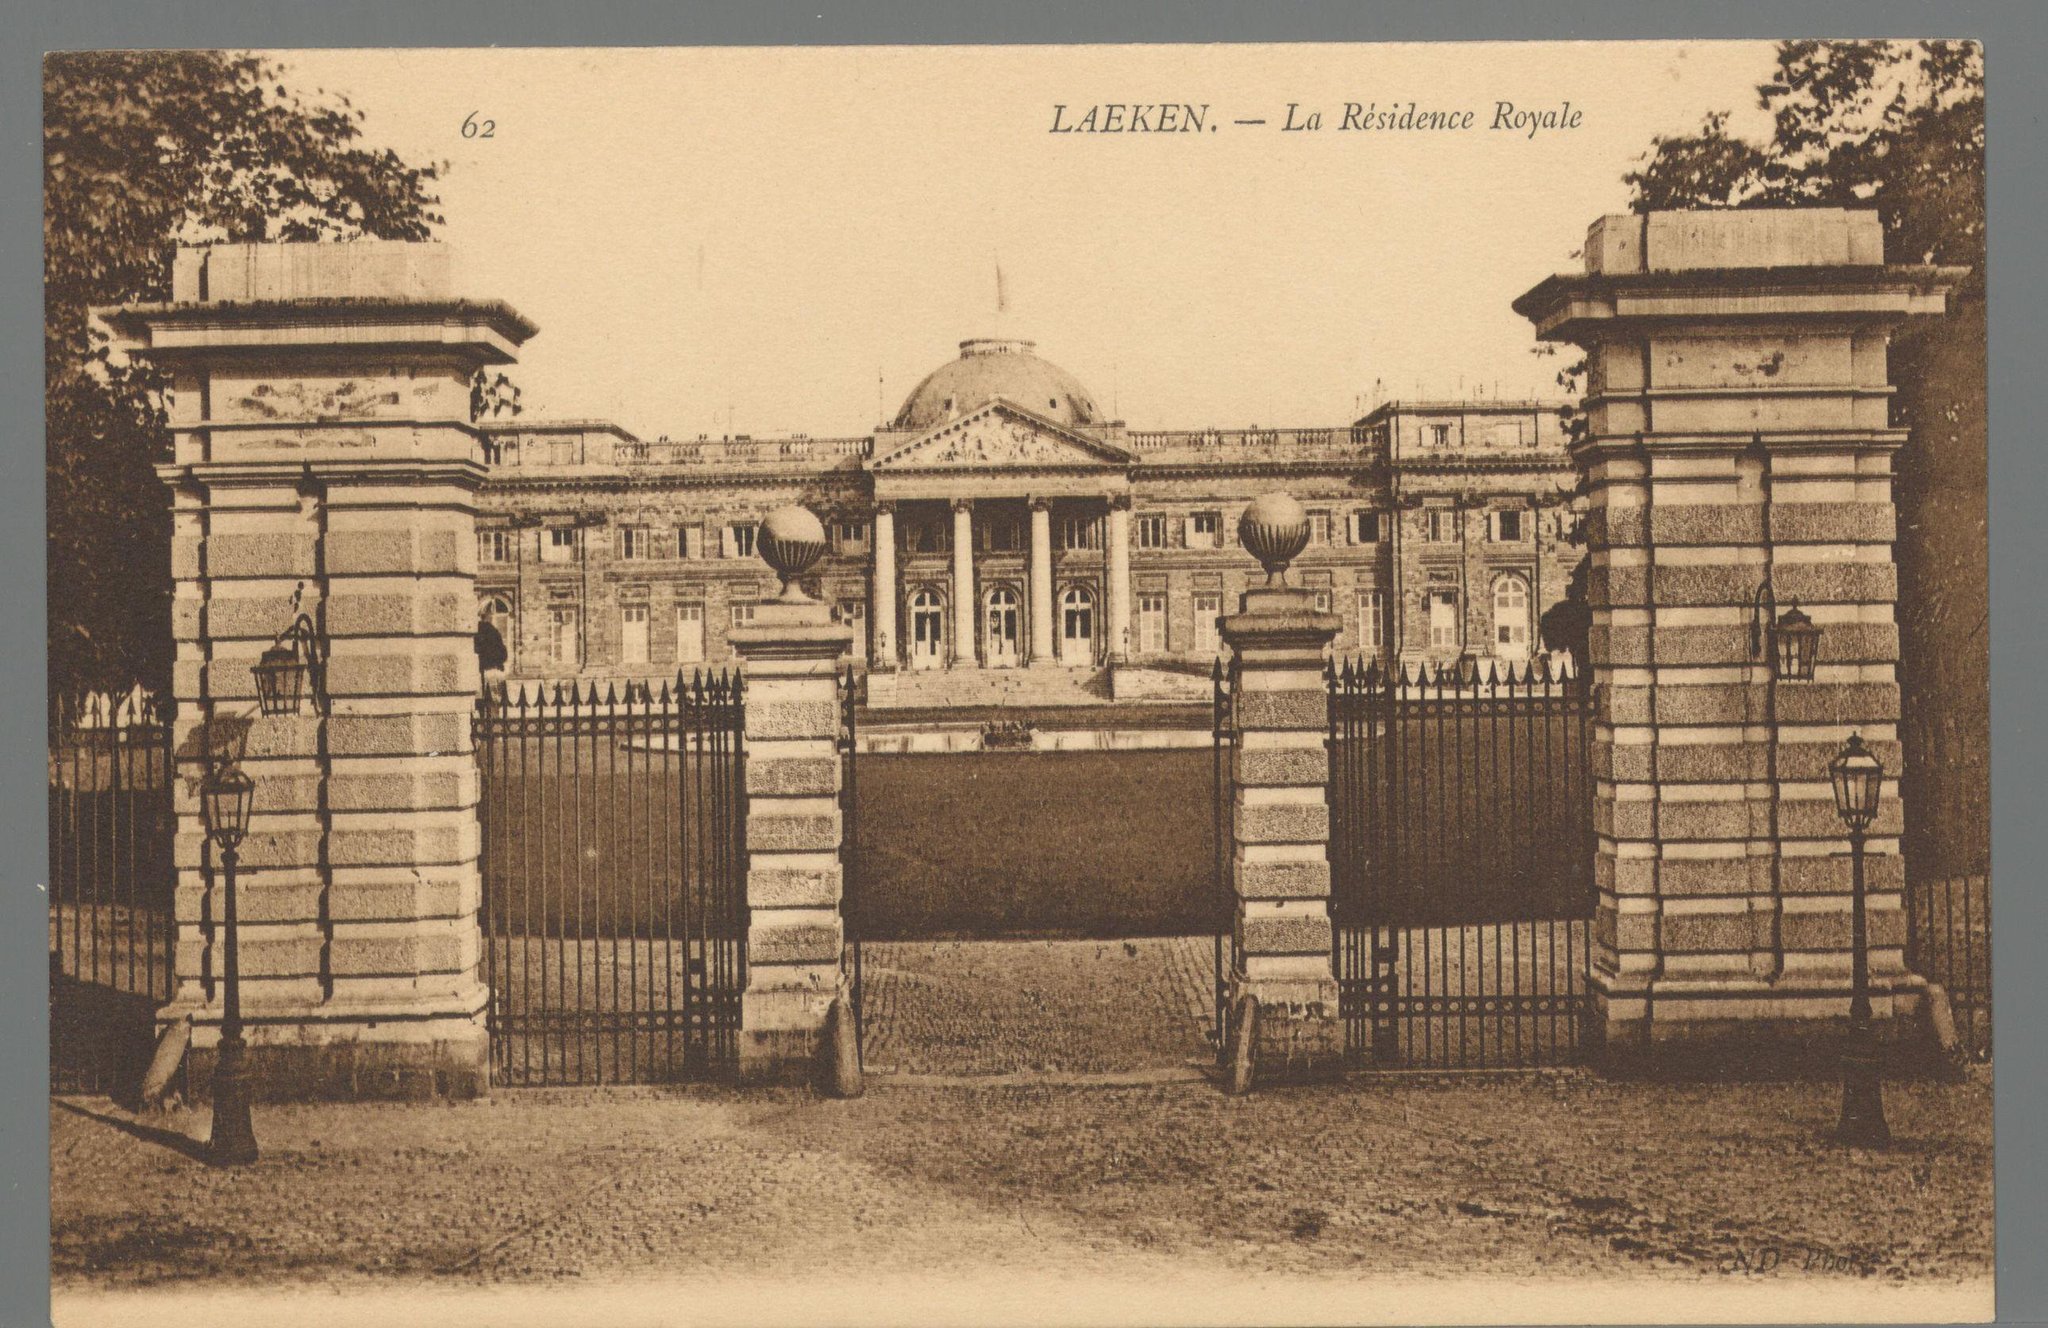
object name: photomechanical print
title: Laeken. La Résidence Royale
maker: Anonymous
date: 1906-1918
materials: cardboard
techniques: photograph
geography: brussels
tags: palace, gate, entrance, laeken